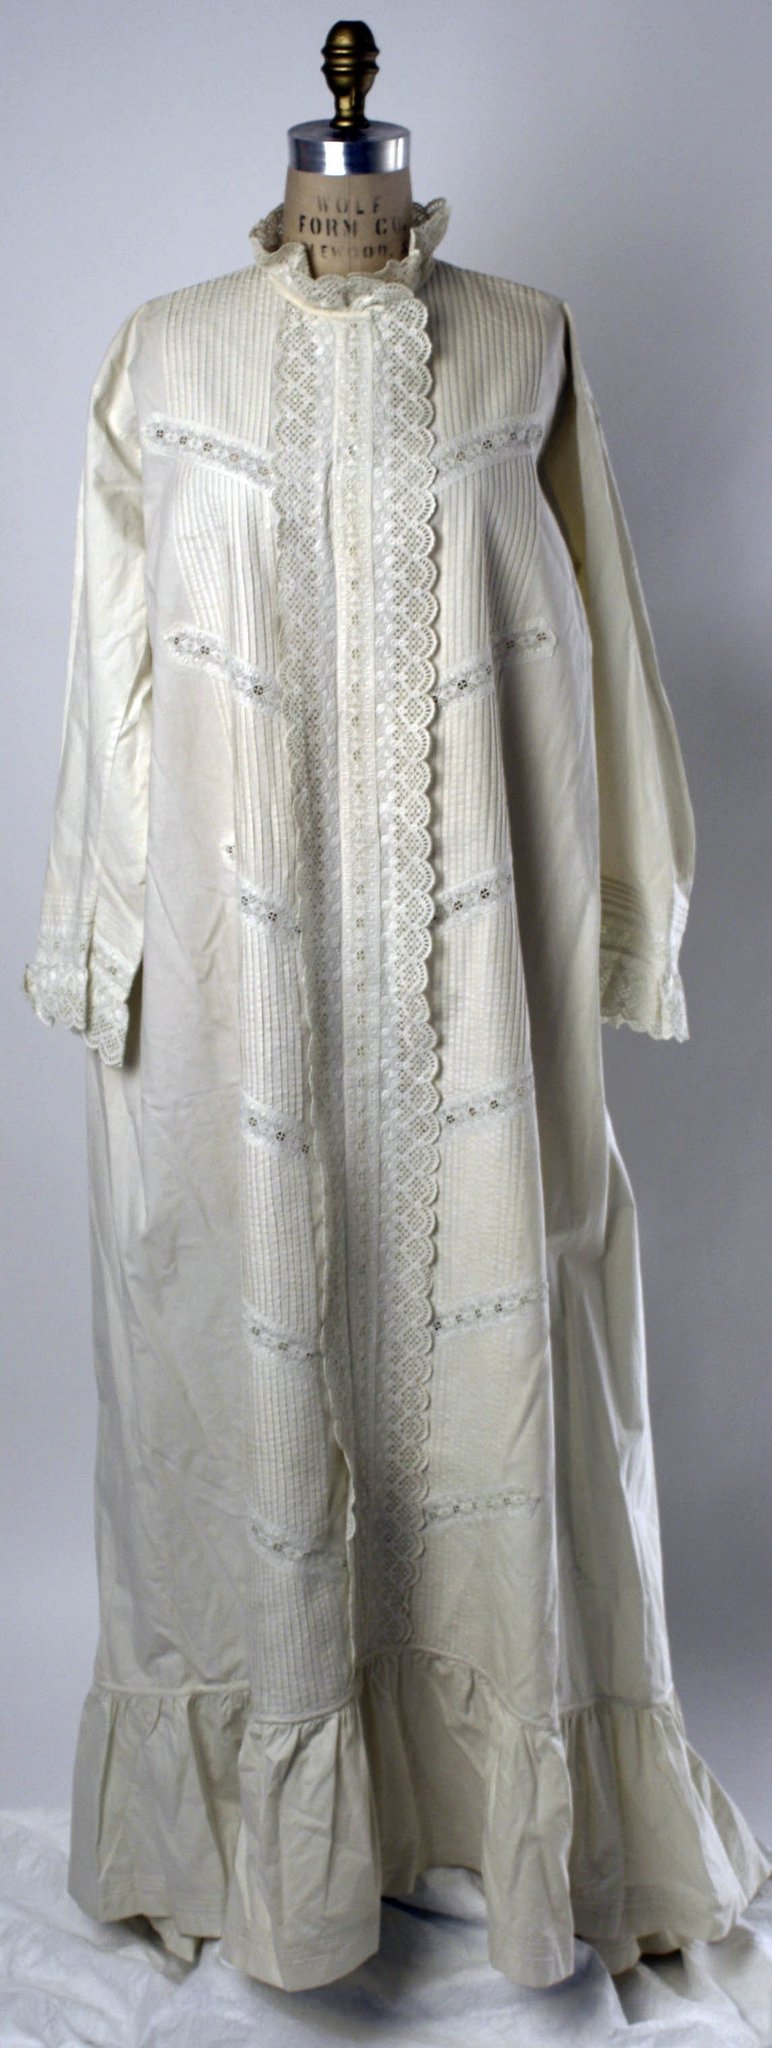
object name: nightgown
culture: american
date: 1870-1879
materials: cotton